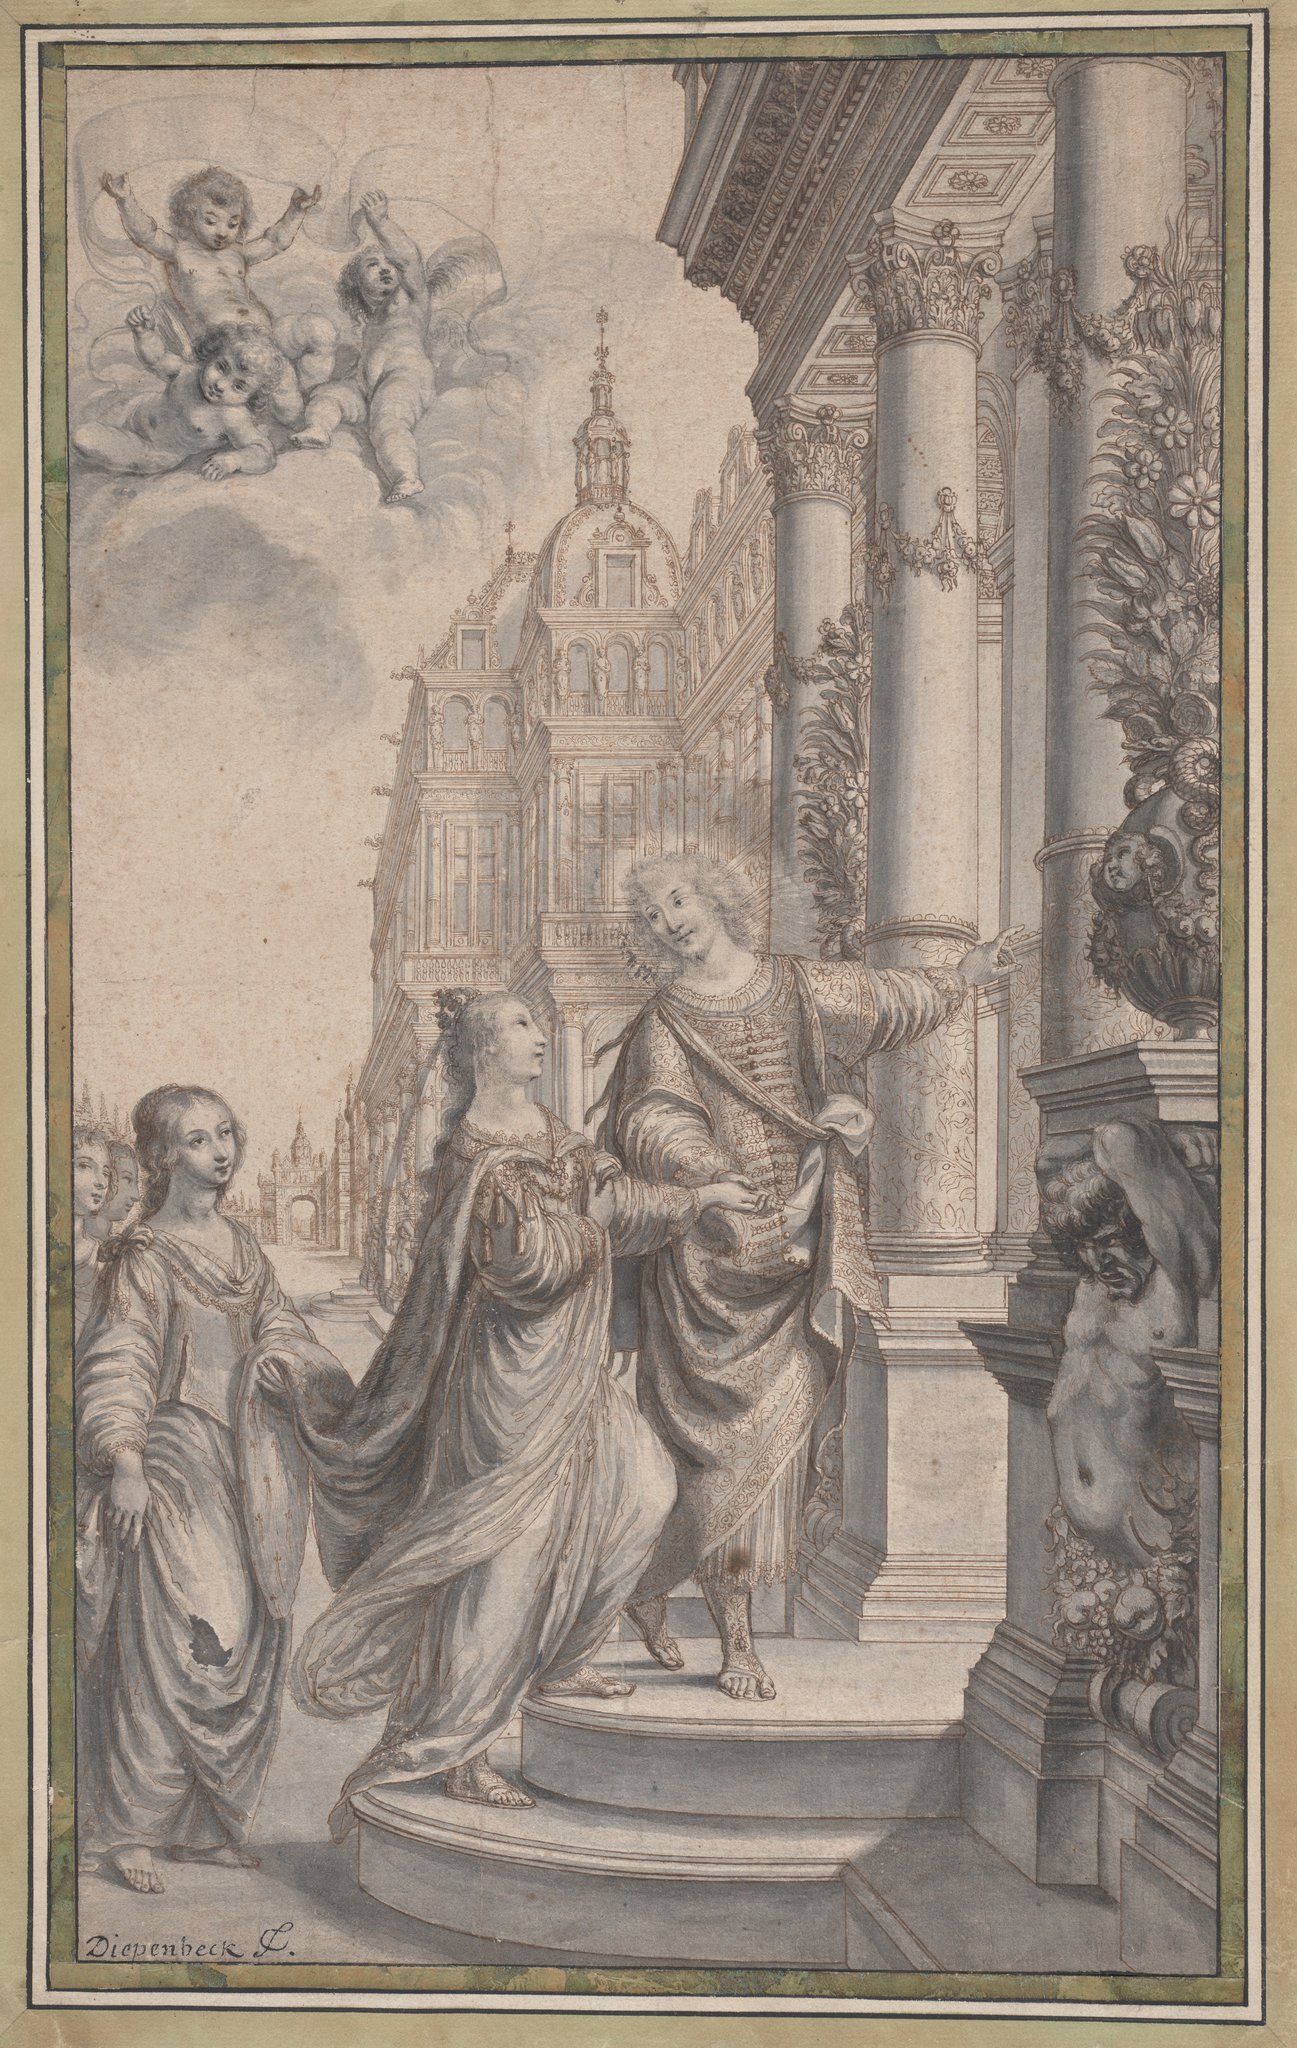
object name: drawing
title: Design for a Frontispiece: A Man Guiding a Crowned Woman and her Attendants to the Entrance of a Palace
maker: grégoire huret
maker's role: artist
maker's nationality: french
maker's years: 1606-1670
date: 1640-1660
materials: chalk, ink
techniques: brush, pen, wash